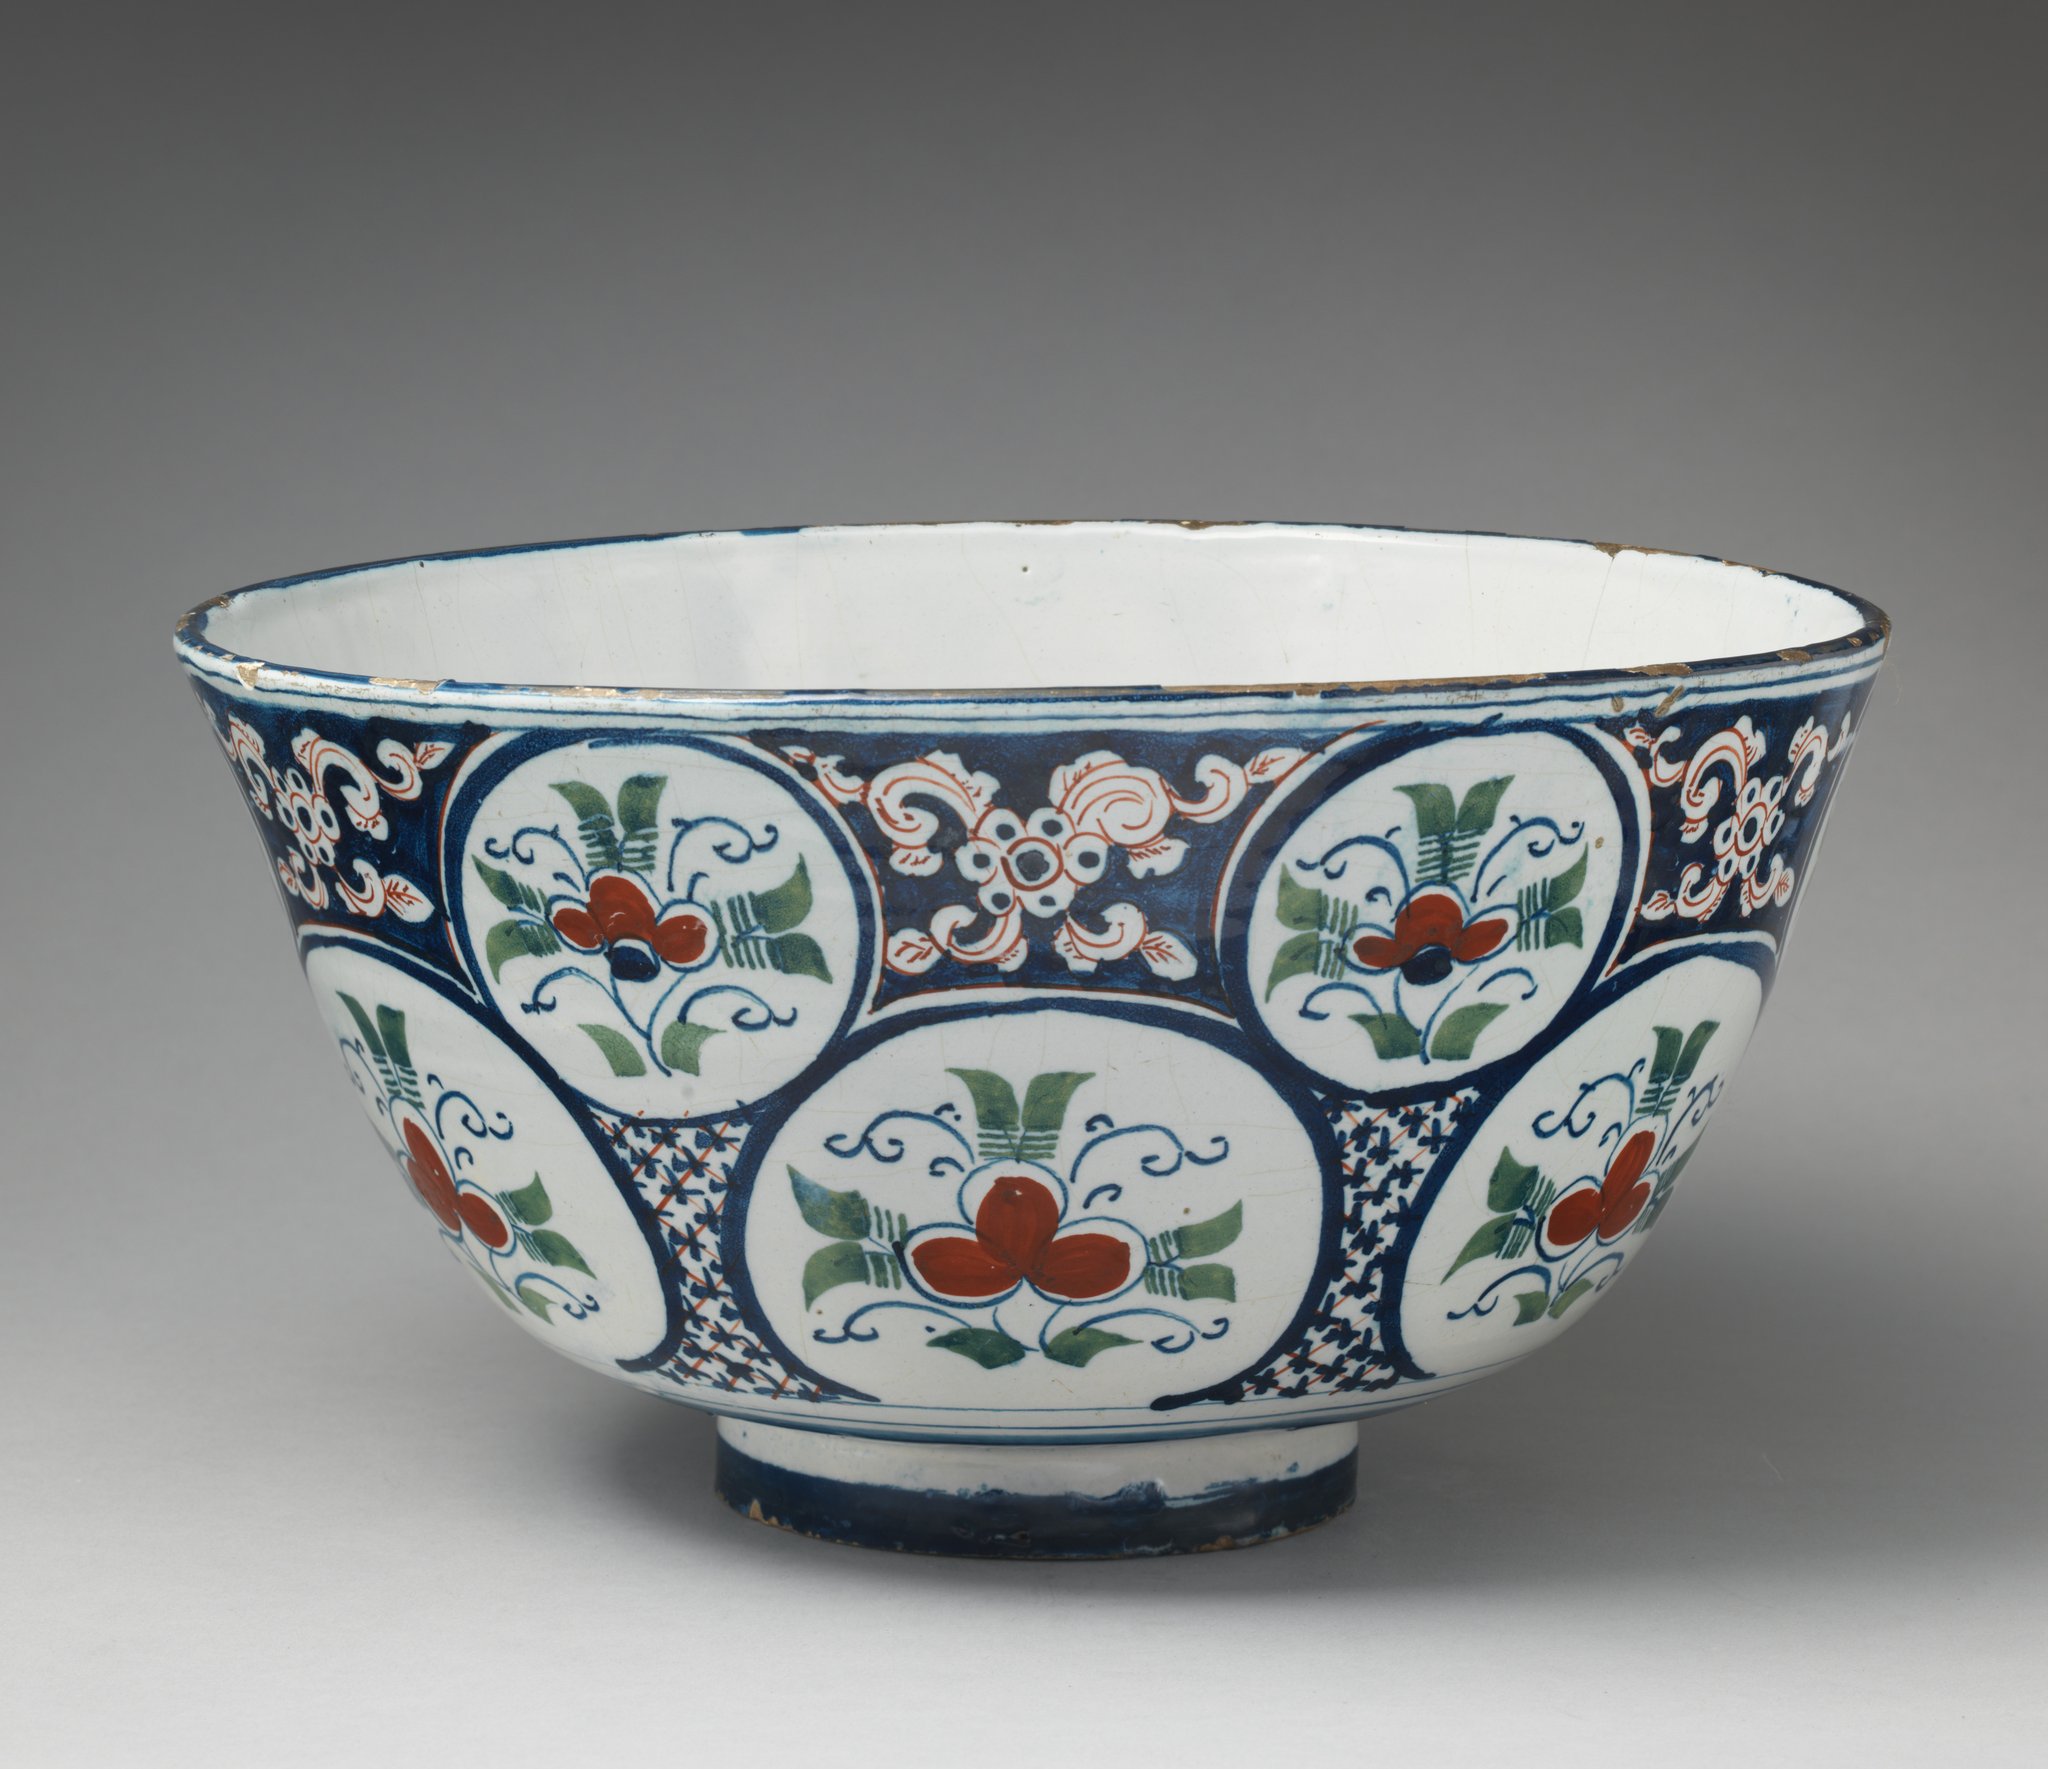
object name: bowl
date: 1720-1730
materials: earthenware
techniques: glazing